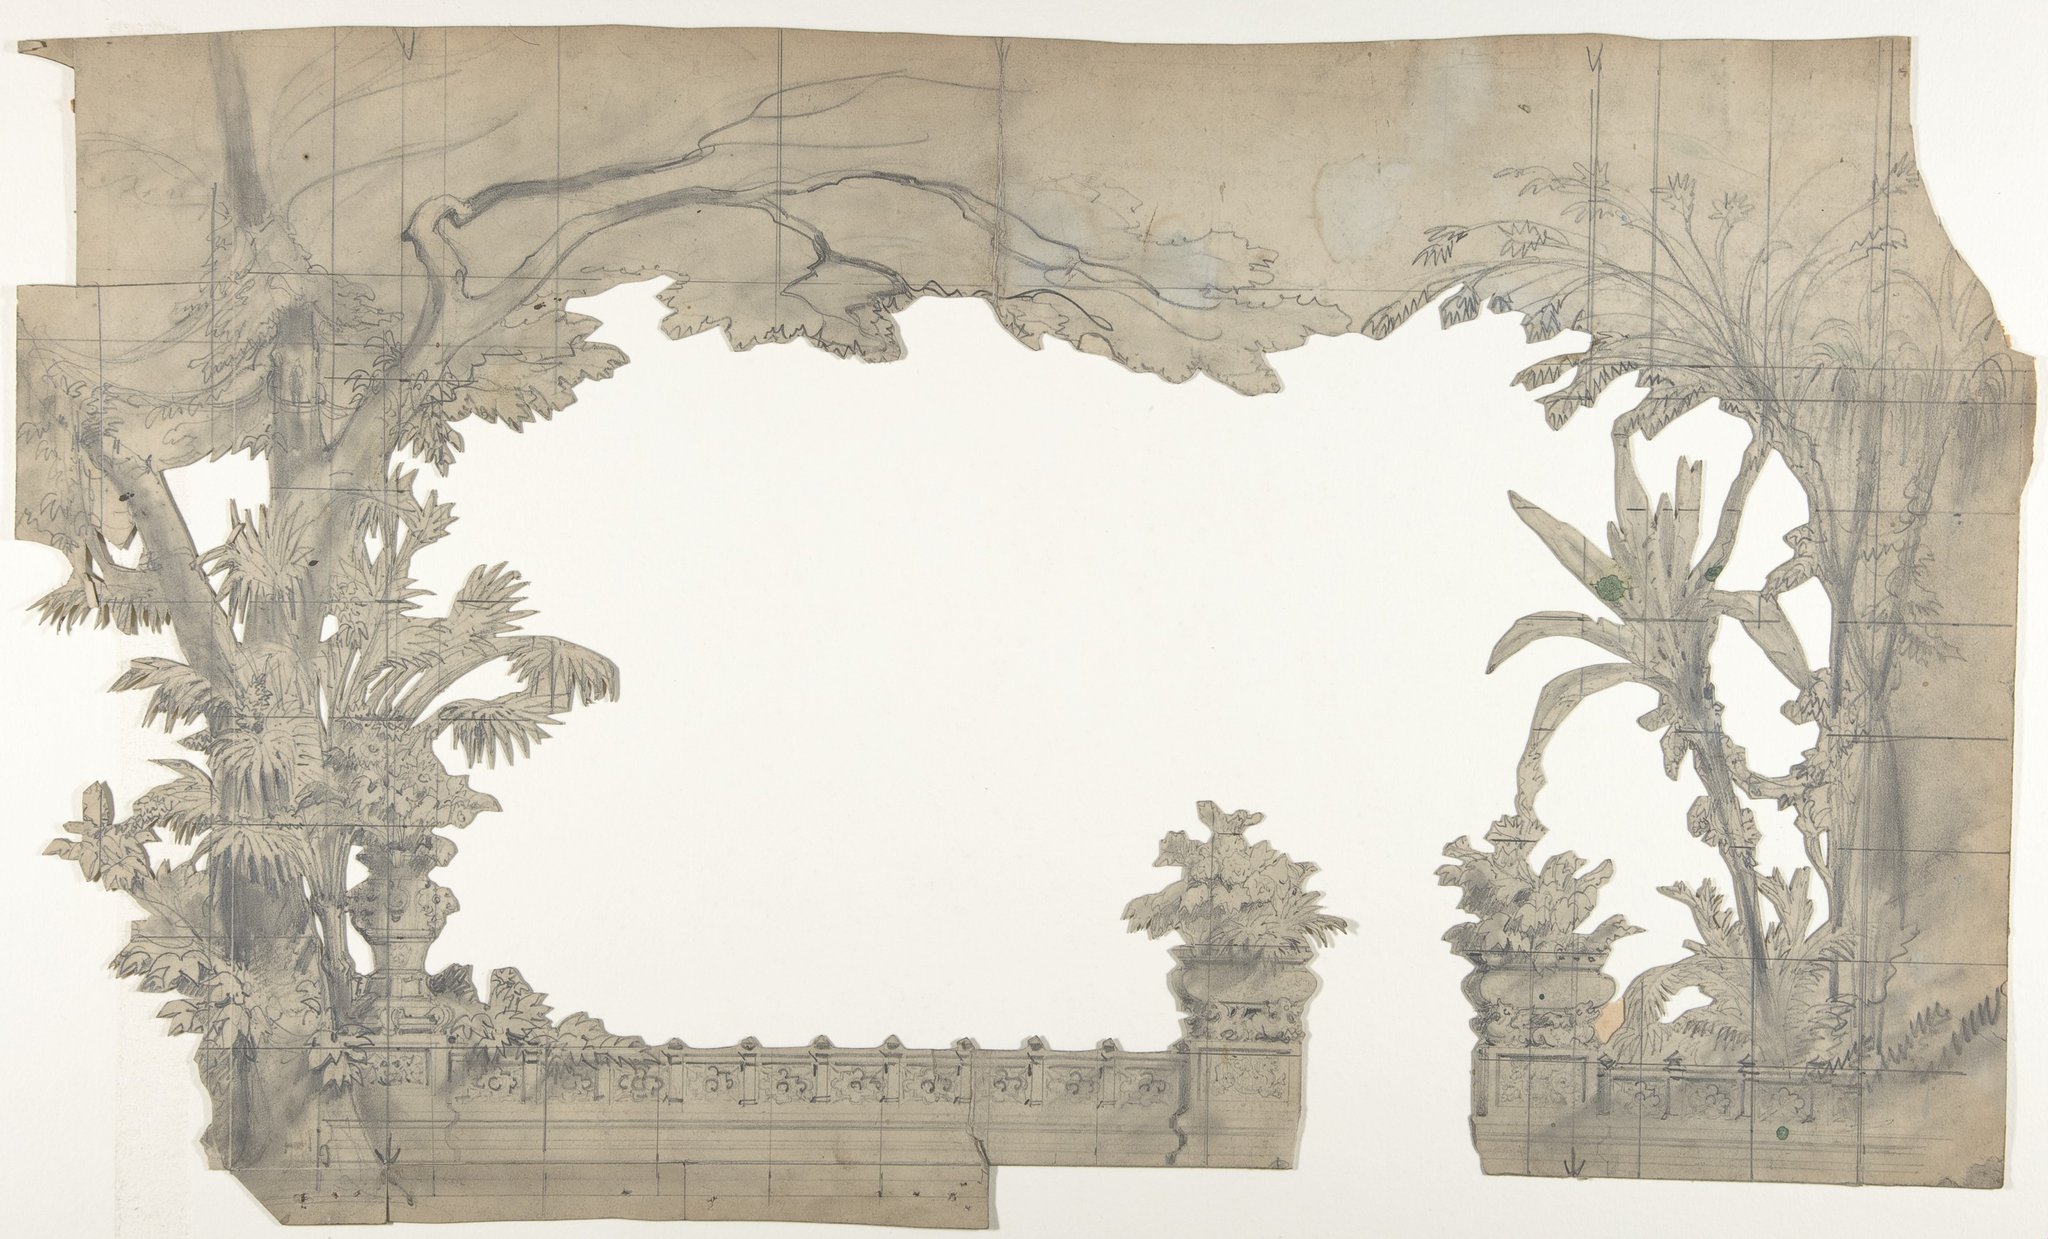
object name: drawing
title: Design for a Stage Set at the Opéra, Paris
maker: eugène cicéri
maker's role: artist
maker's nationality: french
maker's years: 1813-1890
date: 1830-1890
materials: graphite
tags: trees,stage design